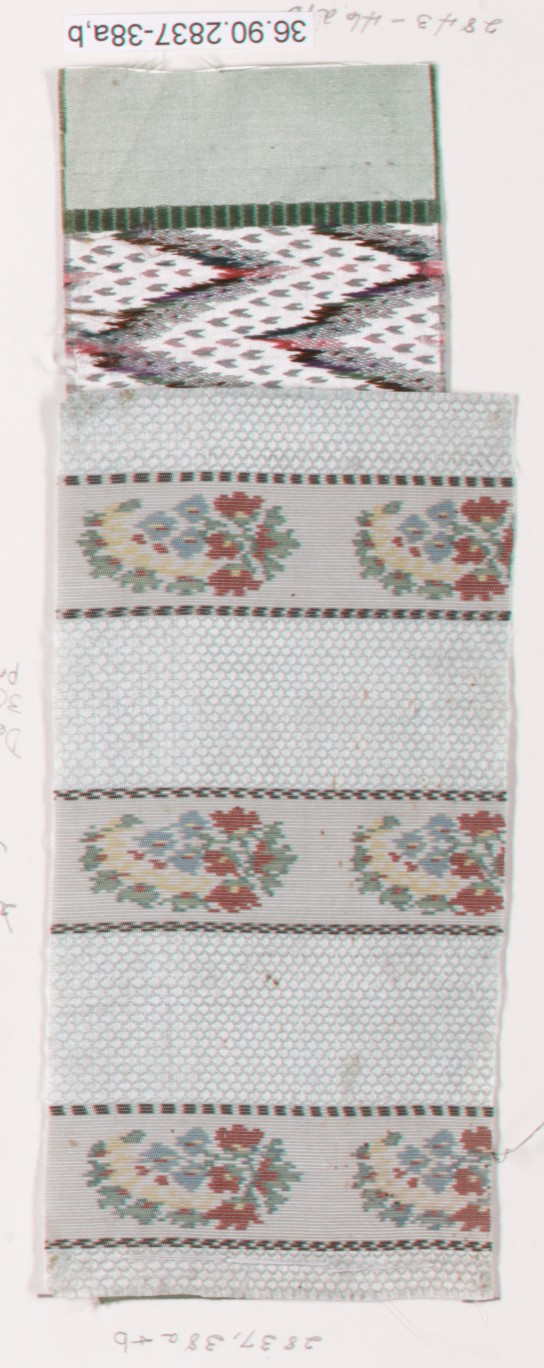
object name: piece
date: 1801-1900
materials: silk